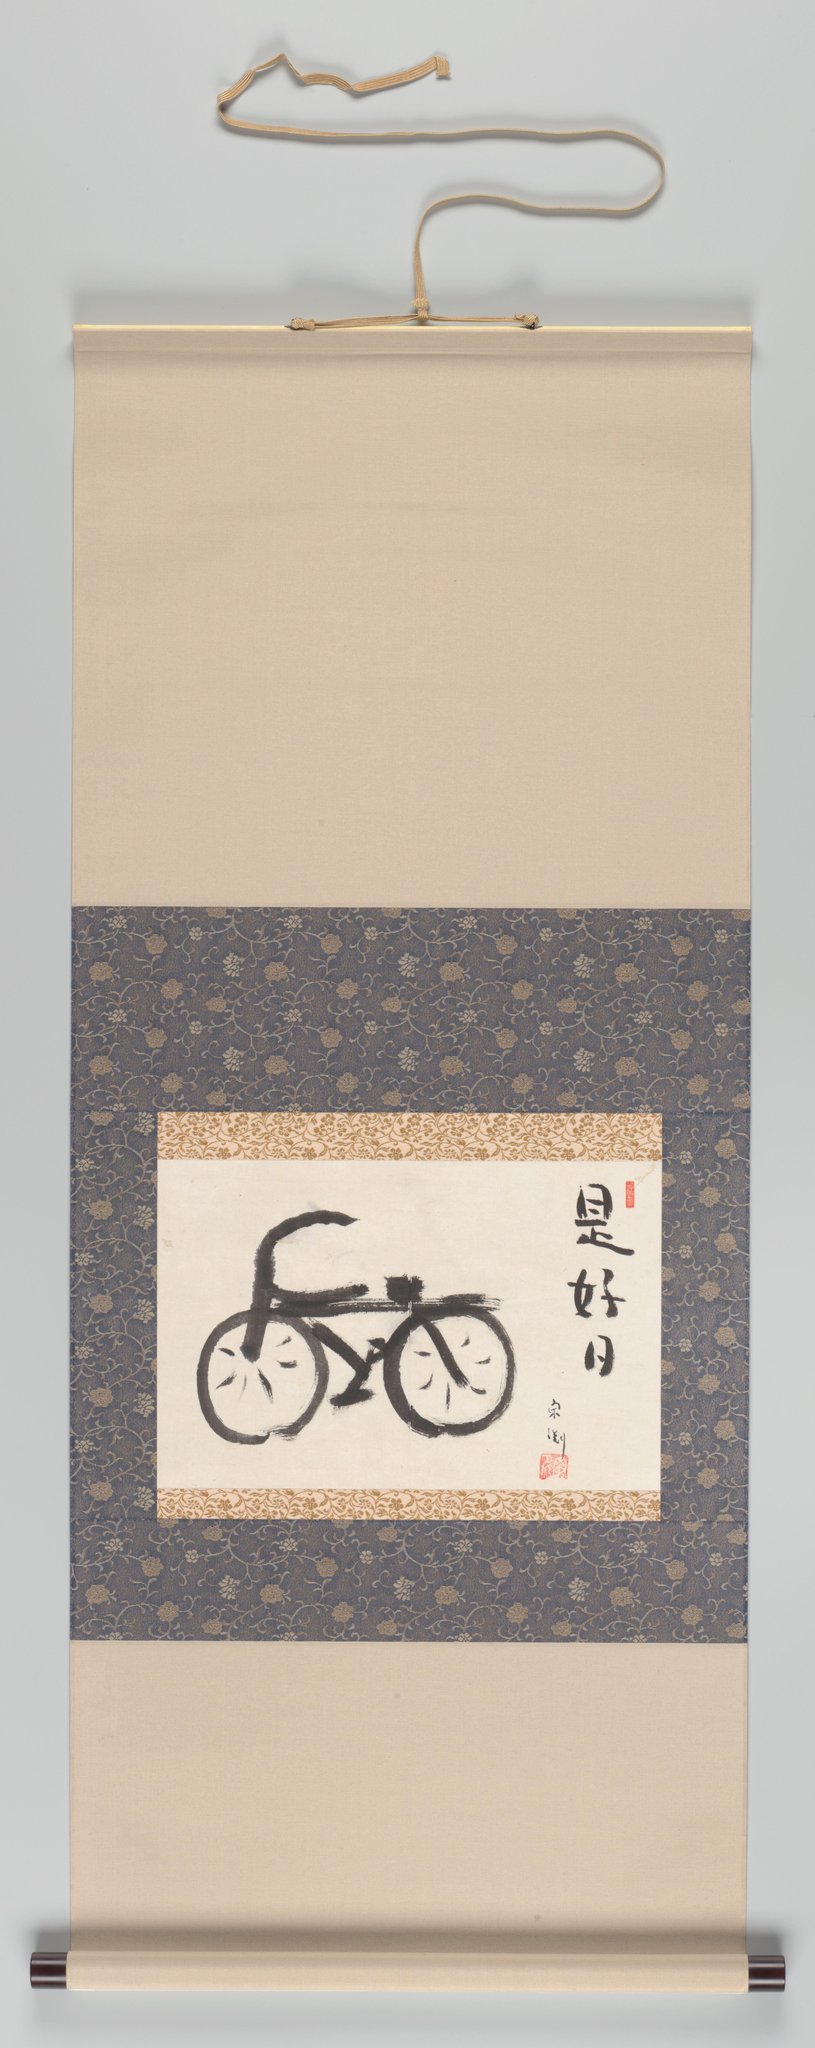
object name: hanging scroll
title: This Good Day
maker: nakagawa sōen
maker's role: painter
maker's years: 1907-1984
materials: ink, paper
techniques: calligraphy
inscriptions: inscription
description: The anatomy of this bicycle is not quite right, but that is not the point. The painting captures the essence of a bicycle. The accompanying inscription reads ‘this good day’. It is taken from a Zen proverb, which invites us to live in the moment and make the most of each day.